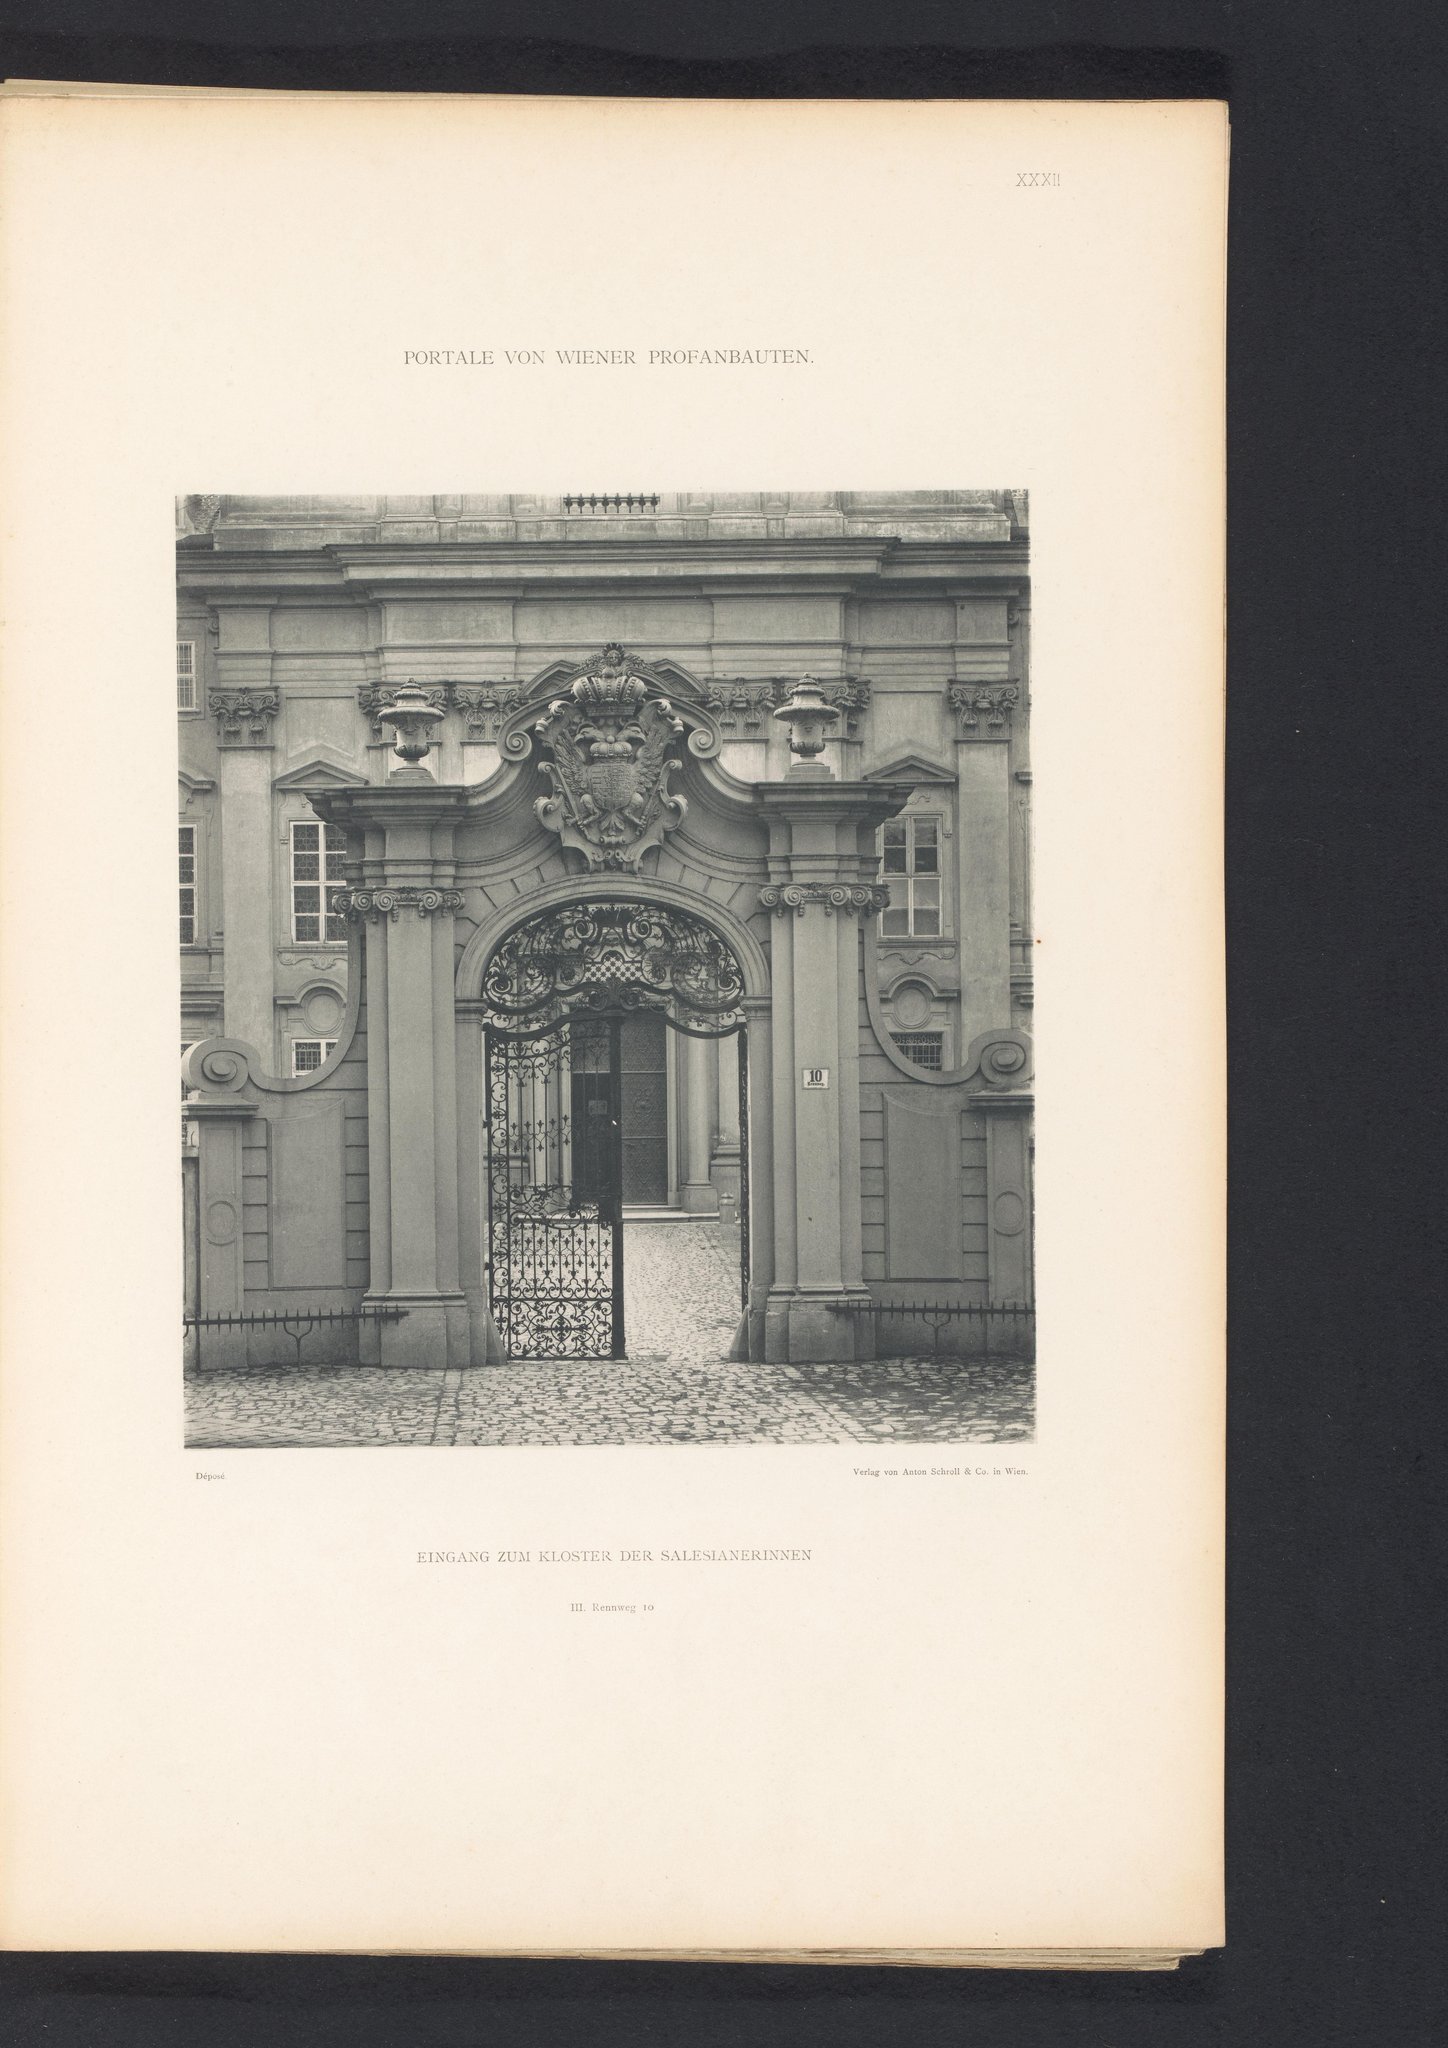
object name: page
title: Eingang zum Kloster der Salesianerinnen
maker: Anonymous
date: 1884-1894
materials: paper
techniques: photograph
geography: vienna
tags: fence, wall, paling, gate, entrance, sculpture (+ relief ~ sculpture)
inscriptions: inscription: ‘III. Rennweg 10’, number: ‘XXXII.’